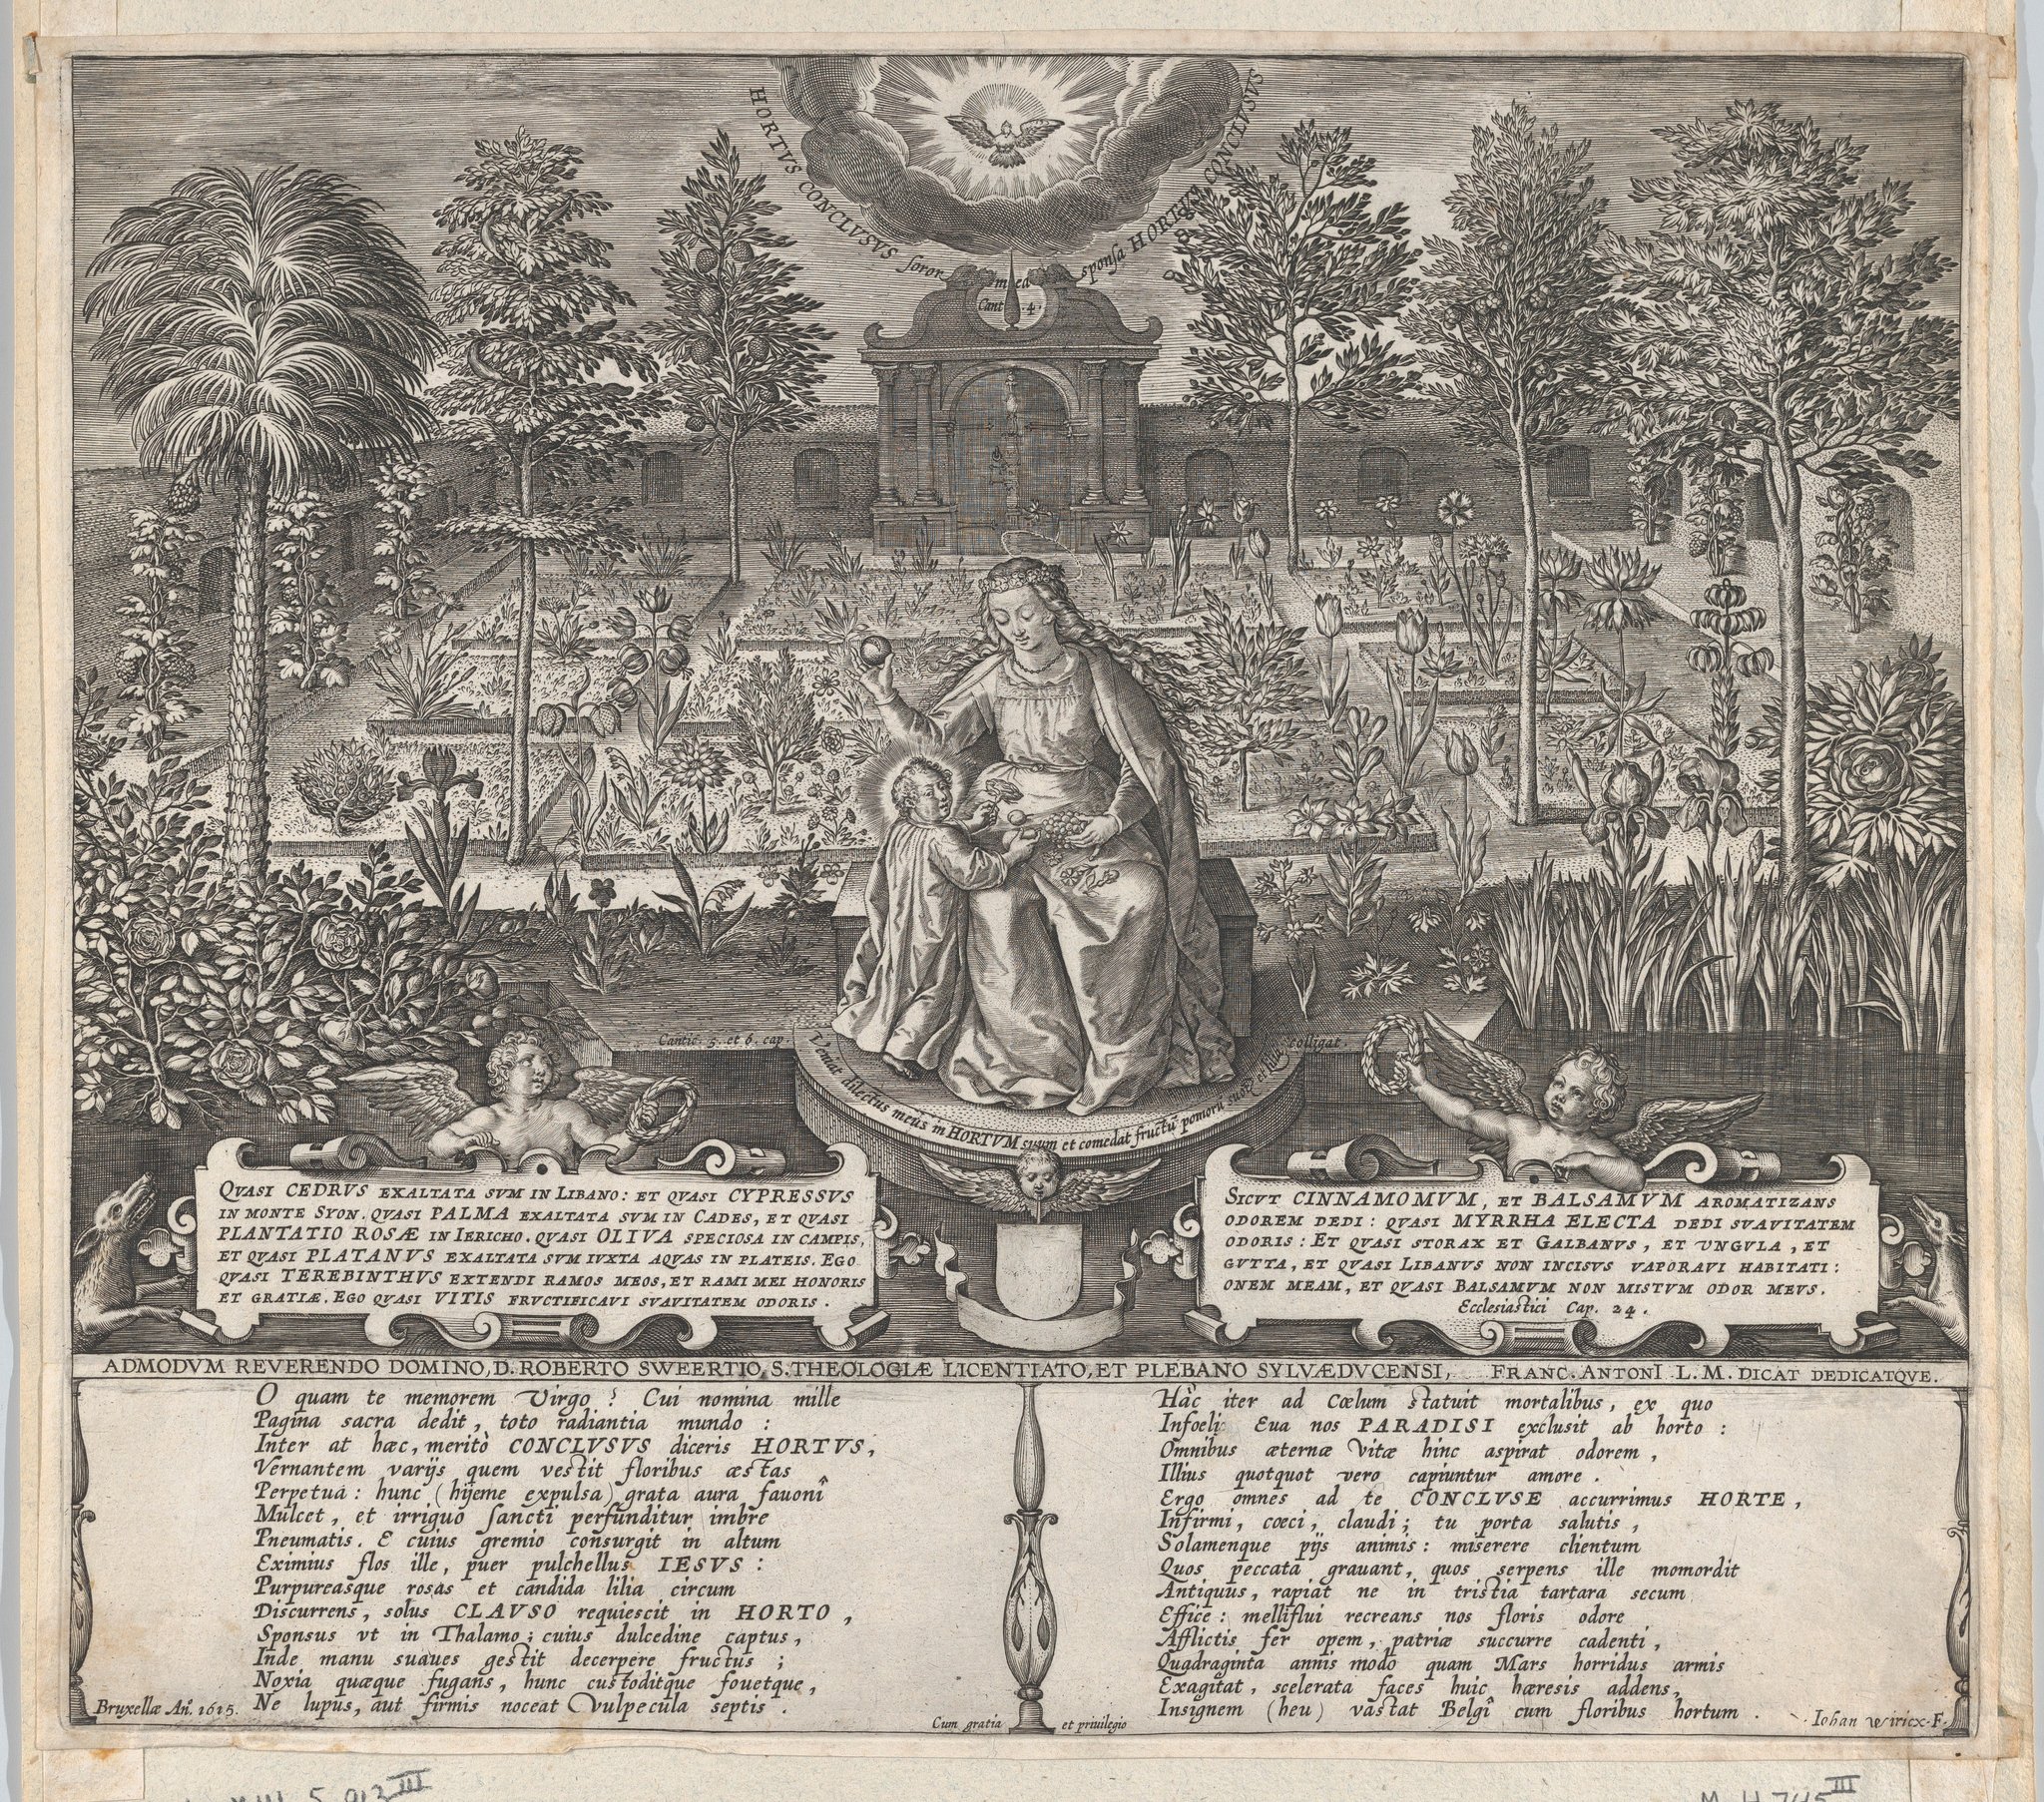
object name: print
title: The Virgin and Child in the Enclosed Garden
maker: jan (johannes) wierix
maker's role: artist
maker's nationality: netherlandish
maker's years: 1549-1615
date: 1606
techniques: engraving